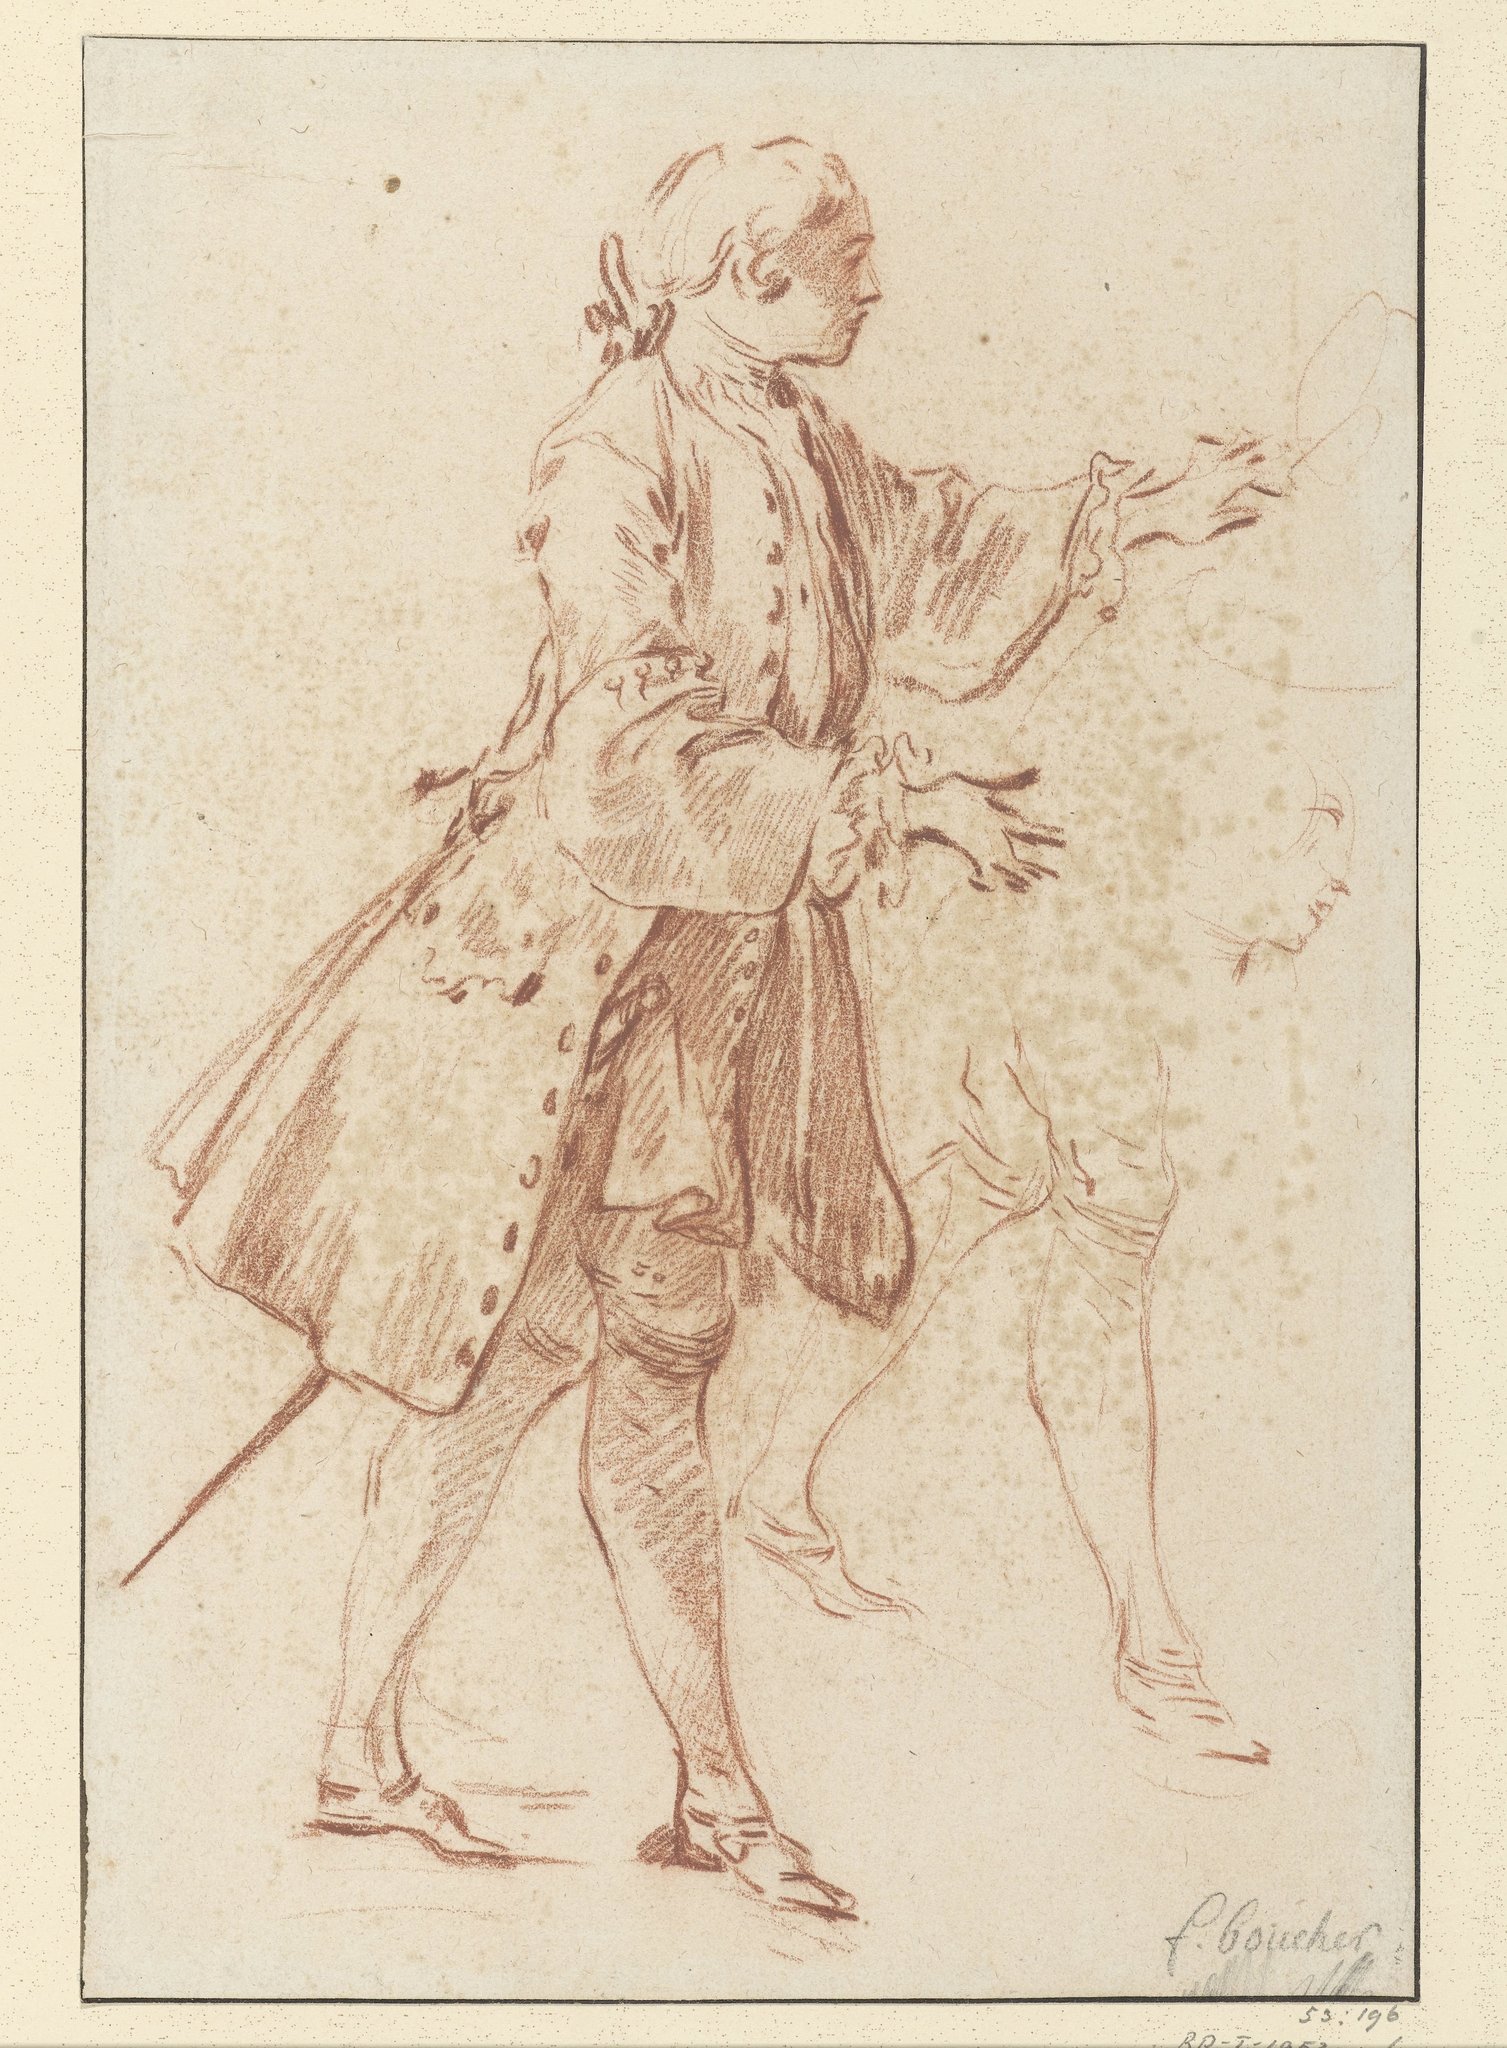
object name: drawing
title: Design for the illustration of "L'Etourdi'' from the 1734 edition of Molière's works (vol. I, p. 3)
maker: françois boucher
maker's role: draughtsman, print maker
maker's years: 1703-1770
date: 1713-1734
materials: chalk, paper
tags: mask, literary characters and objects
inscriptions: signature, verso, lower right, pencil: ‘f. boucher’